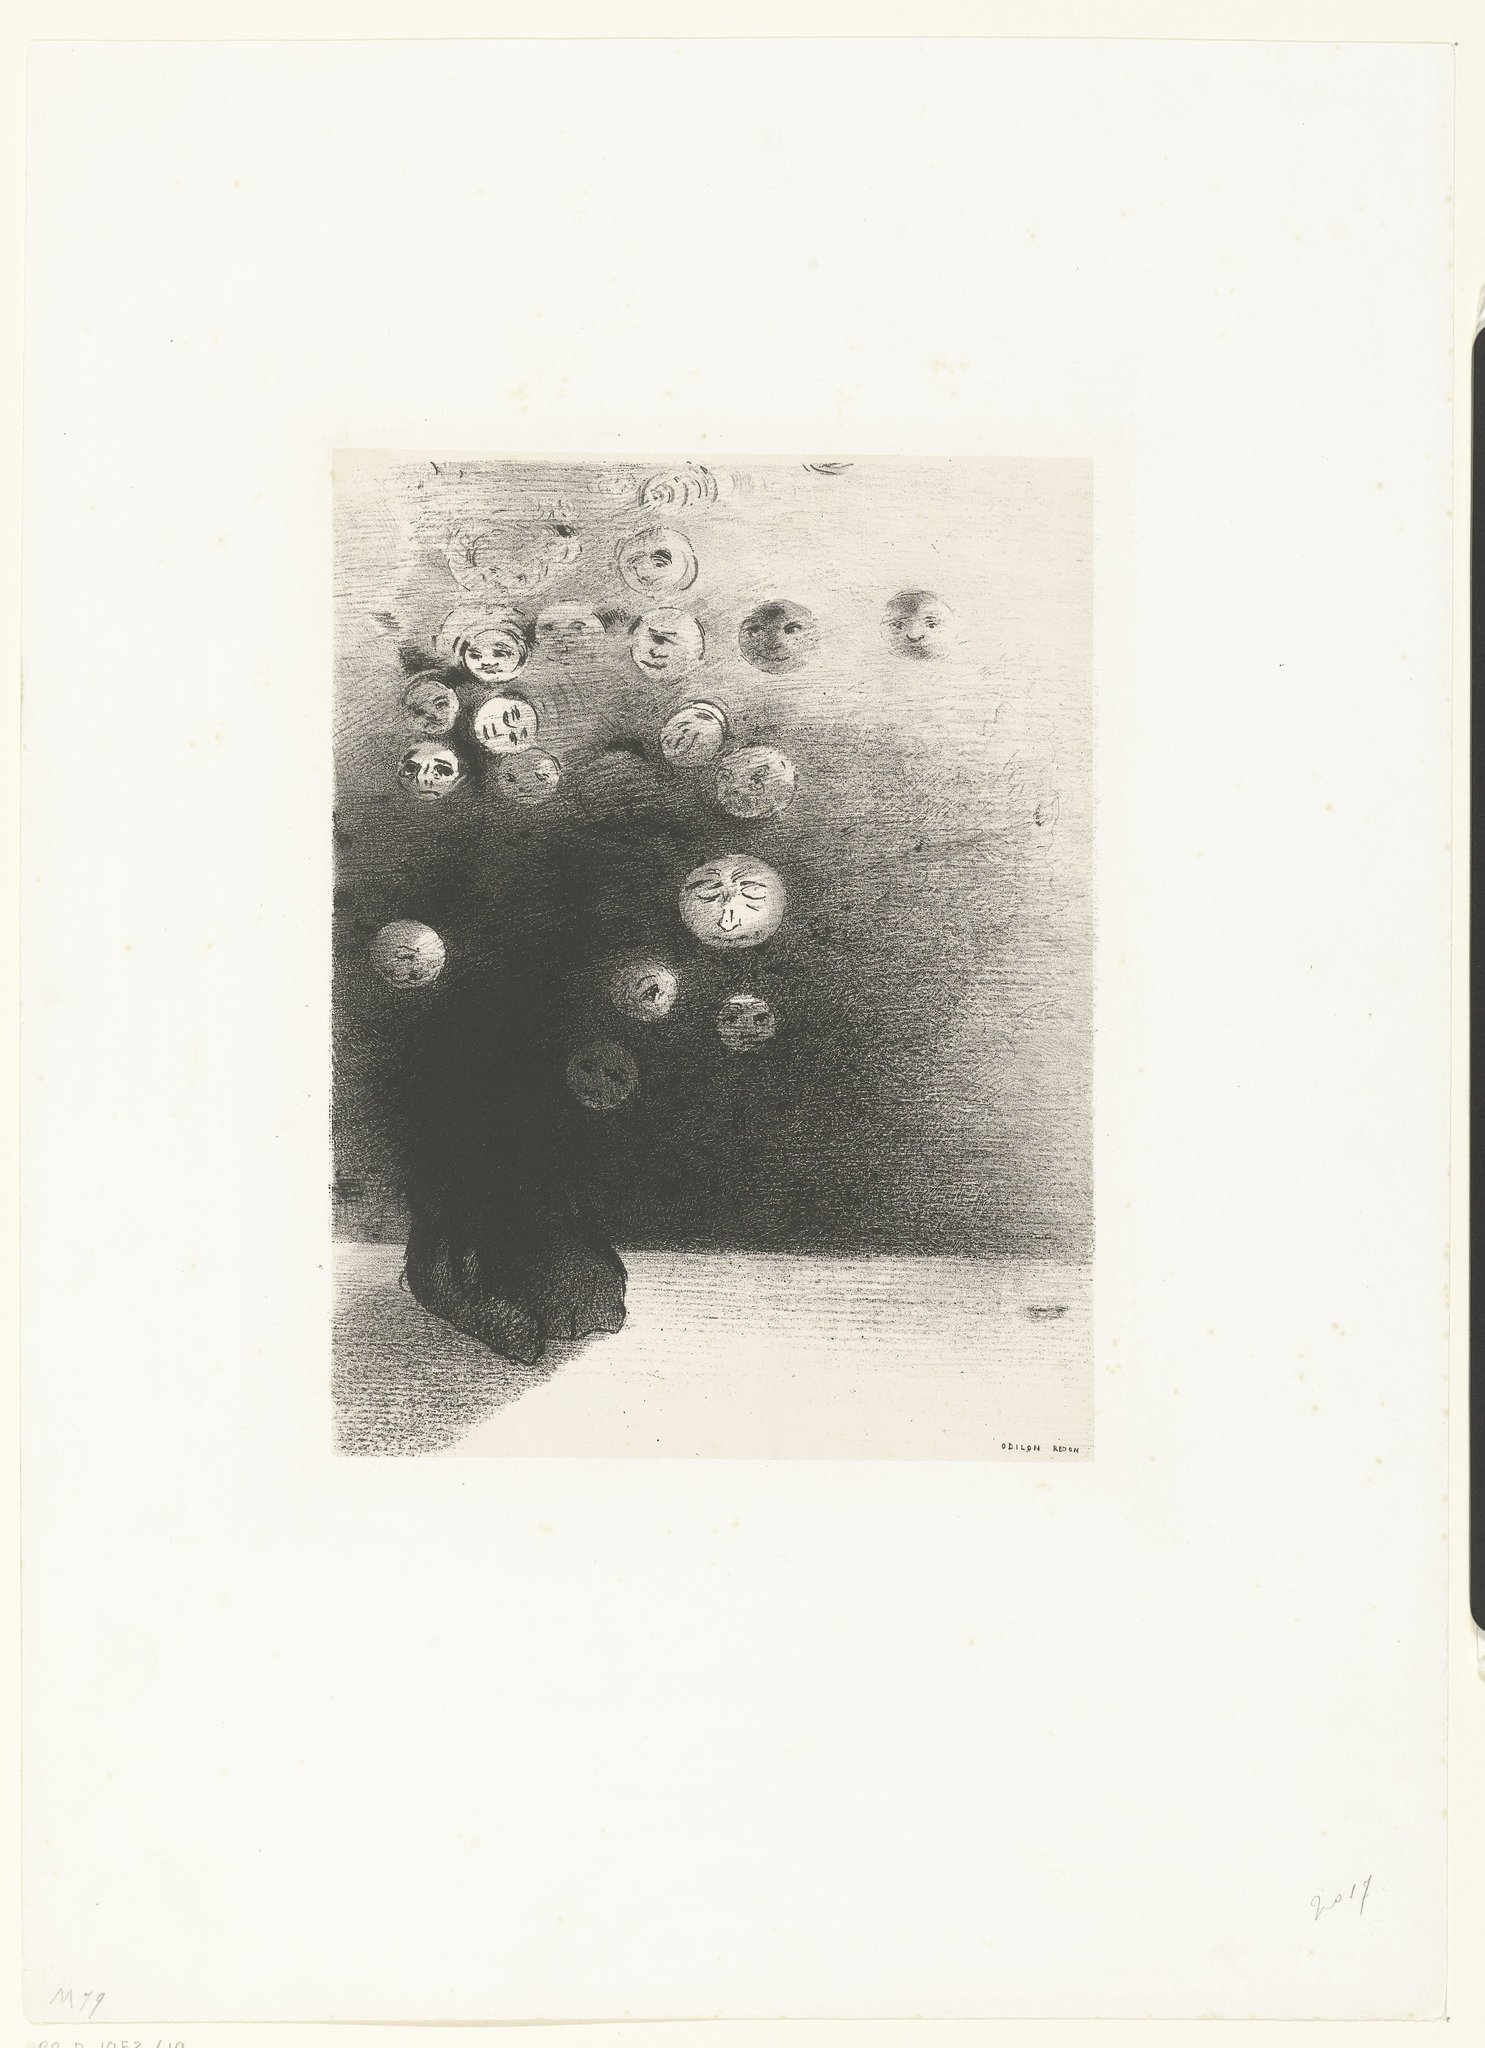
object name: print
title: Is er geen onzichtbare wereld?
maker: odilon redon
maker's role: draughtsman, painter, print maker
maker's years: 1840-1916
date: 1887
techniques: printmaking, lithograph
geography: paris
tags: face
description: Een vage figuur gaat op in de zwarte achtergrond. Er omheen zweven bollen met menselijke gezichten. Vijfde prent uit en serie van zeven illustraties voor het monodrama Le Juré.